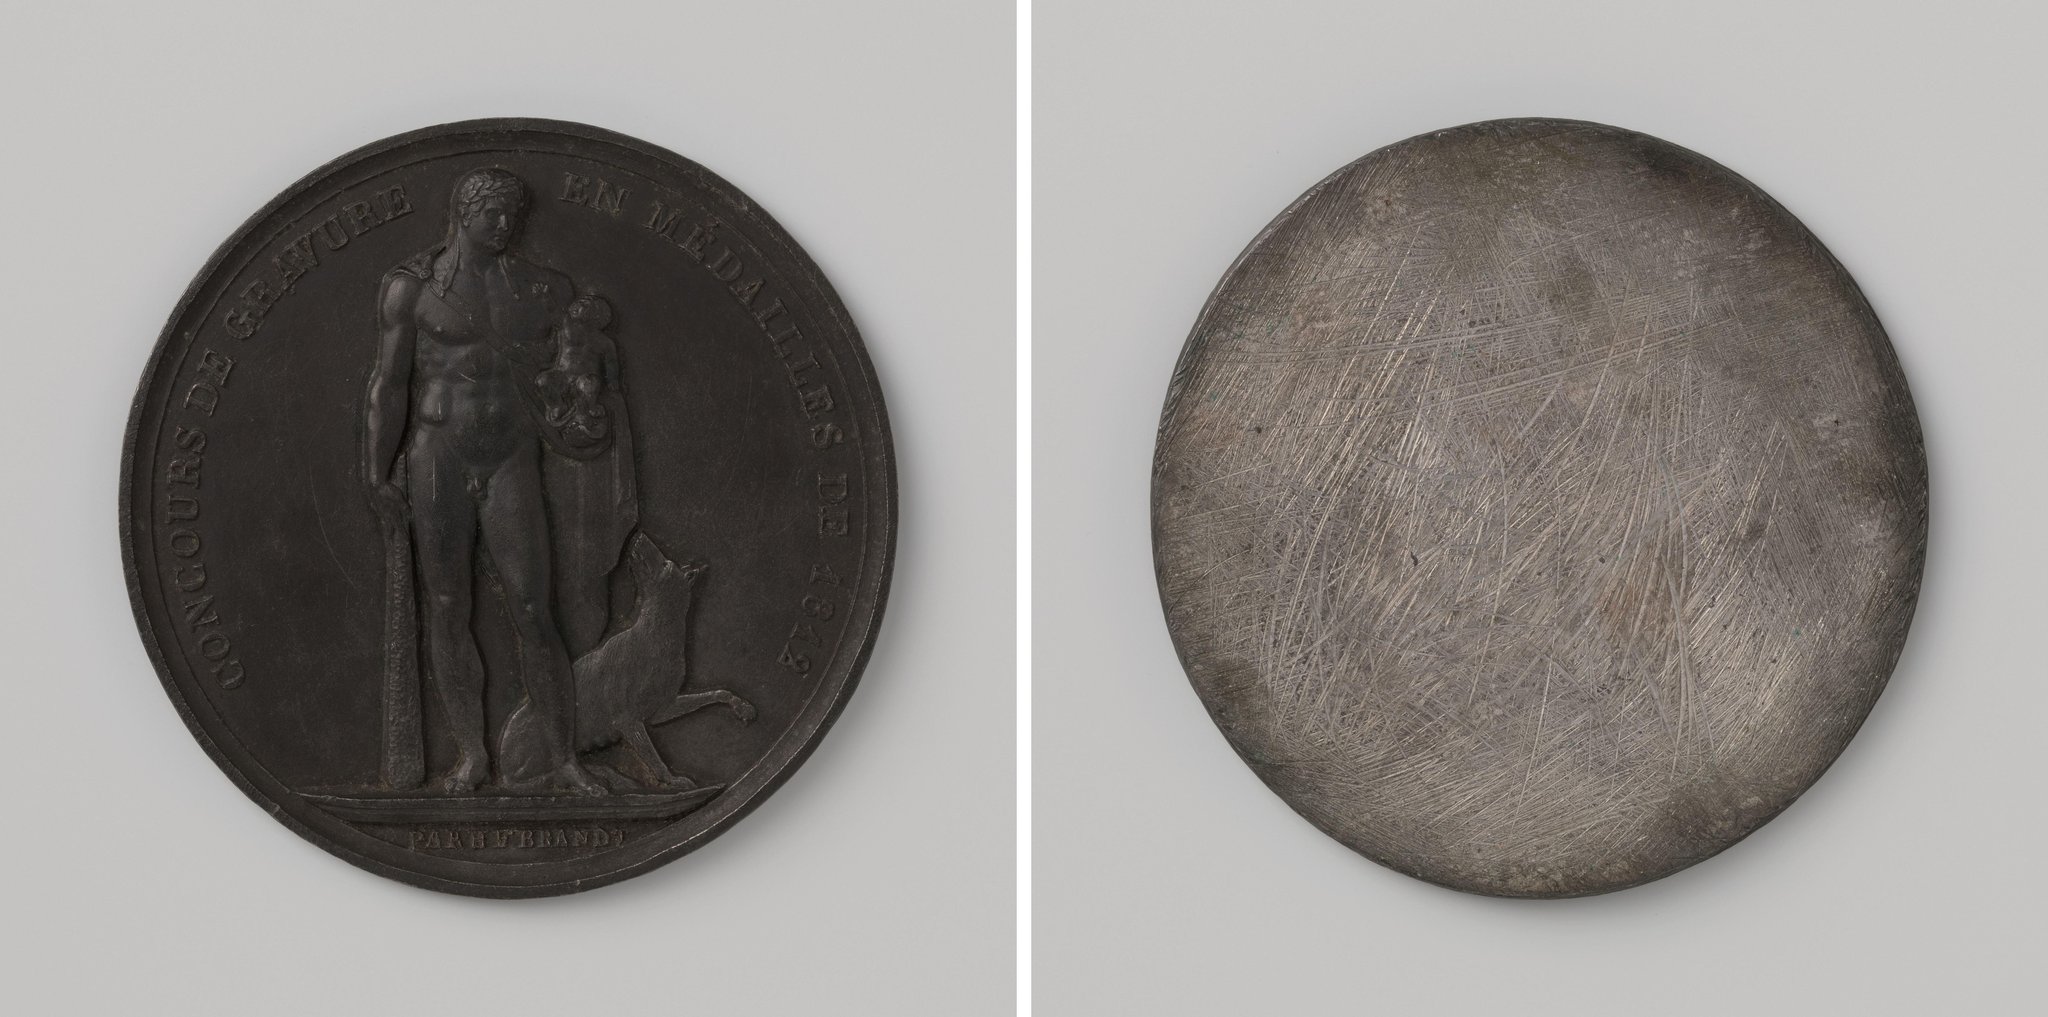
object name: copy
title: Hercules en de koning van Rome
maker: henri-françois brandt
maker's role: painter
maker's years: 1789-1845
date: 1812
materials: lead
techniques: striking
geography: paris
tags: paris, vienna